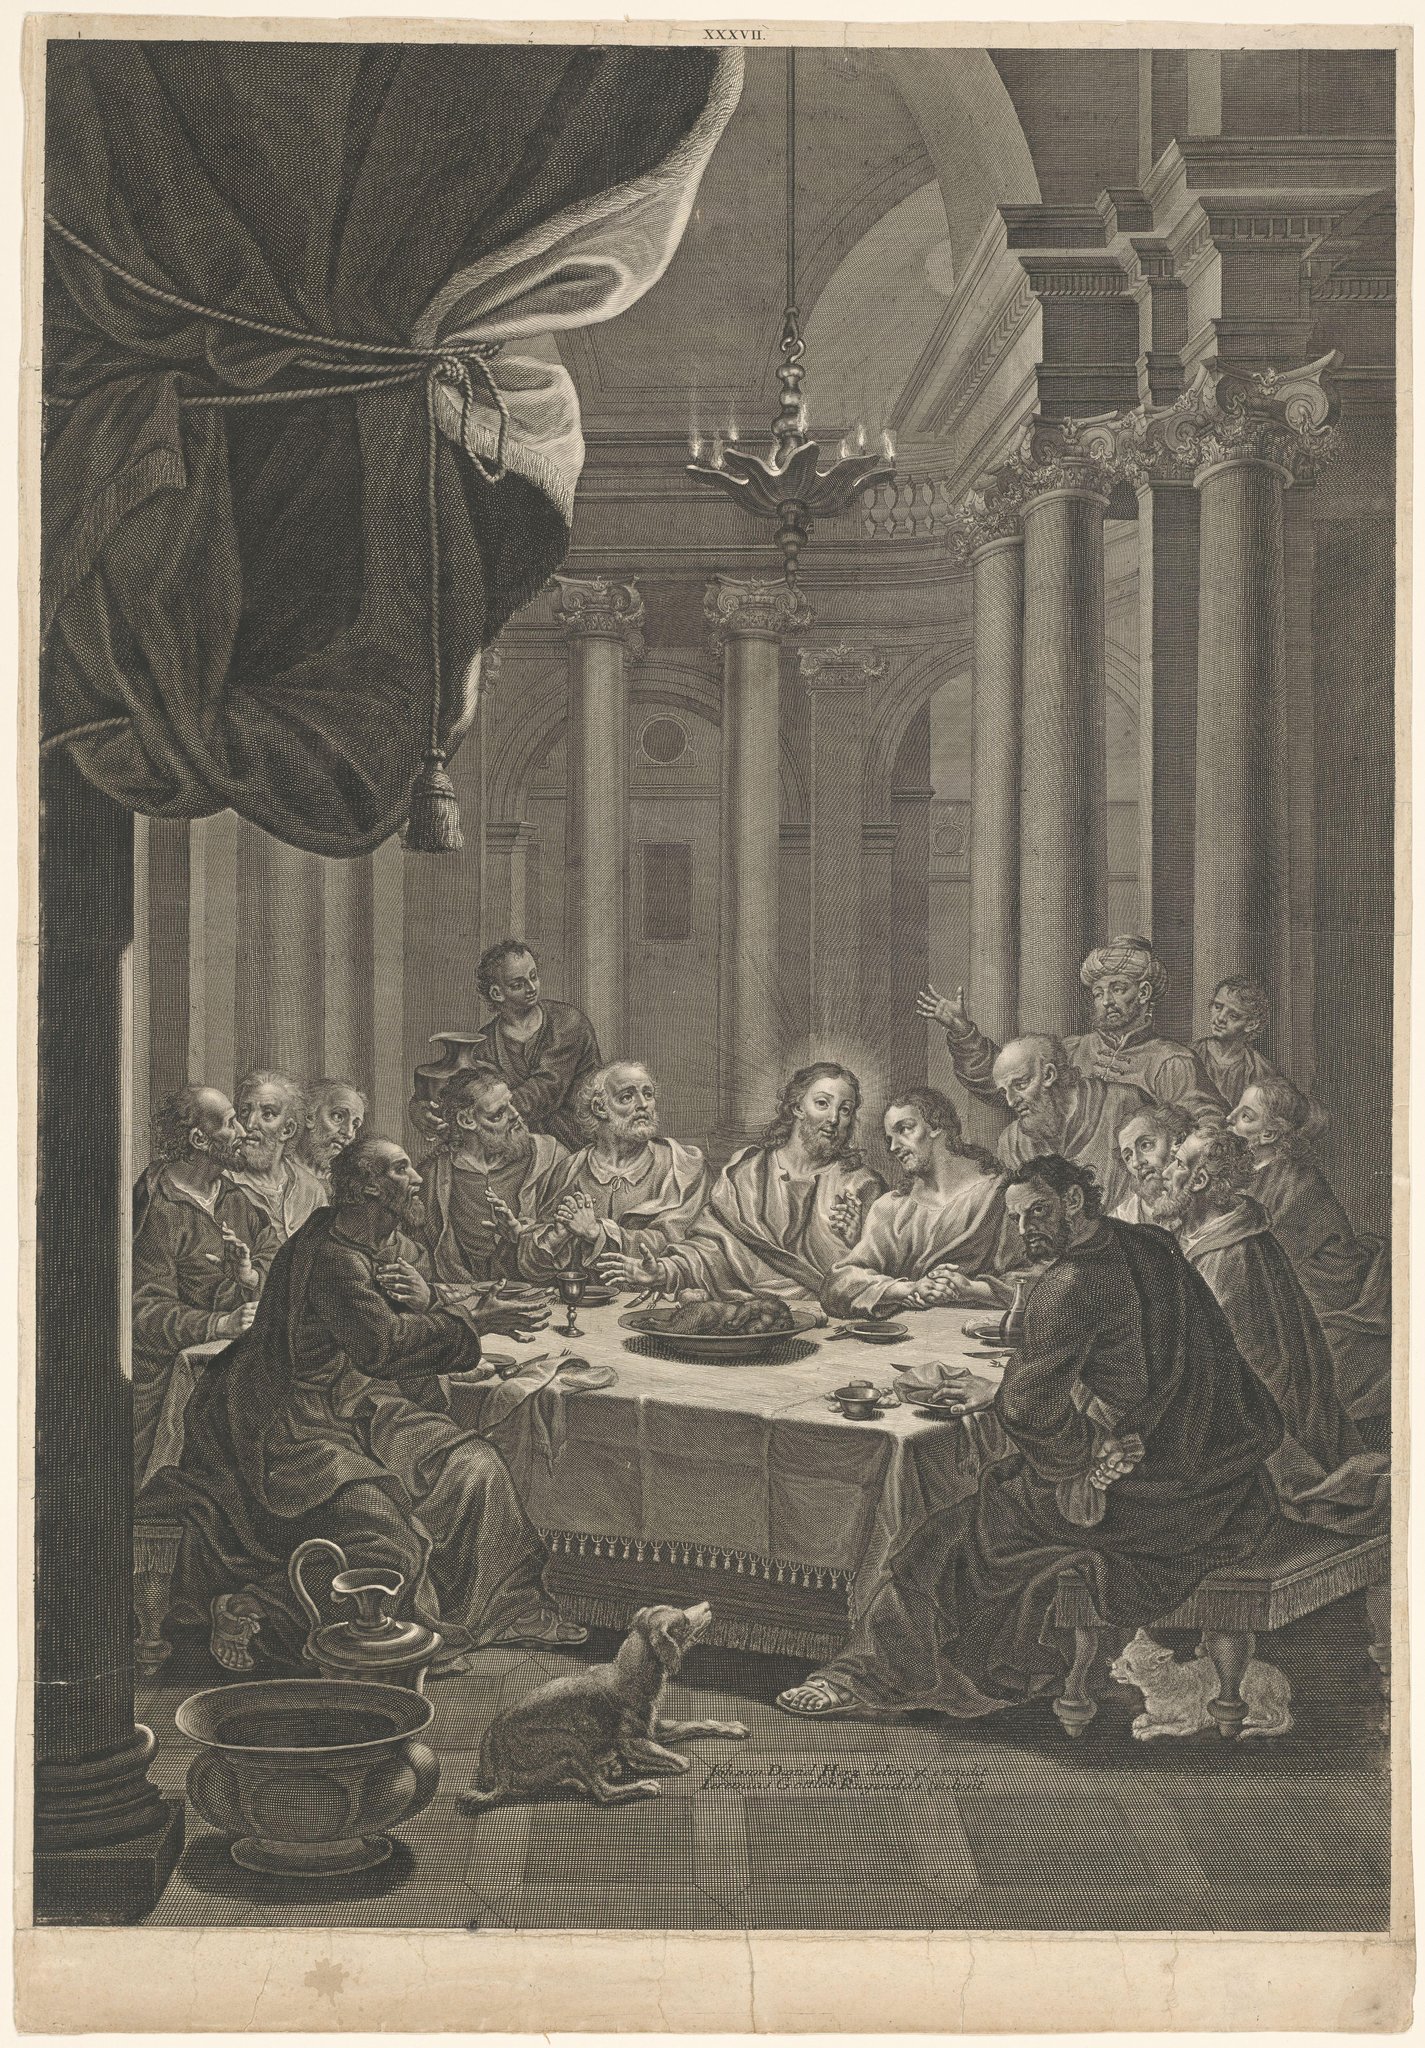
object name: print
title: Laatste Avondmaal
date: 1730-1772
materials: paper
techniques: engraving, etching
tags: last supper (in general) (matthew 26:21-35; mark 14:18-31; luke 22:3, 22:15-23; john 13:21-38)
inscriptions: number: ‘2586’, collector's mark: Lugt 240